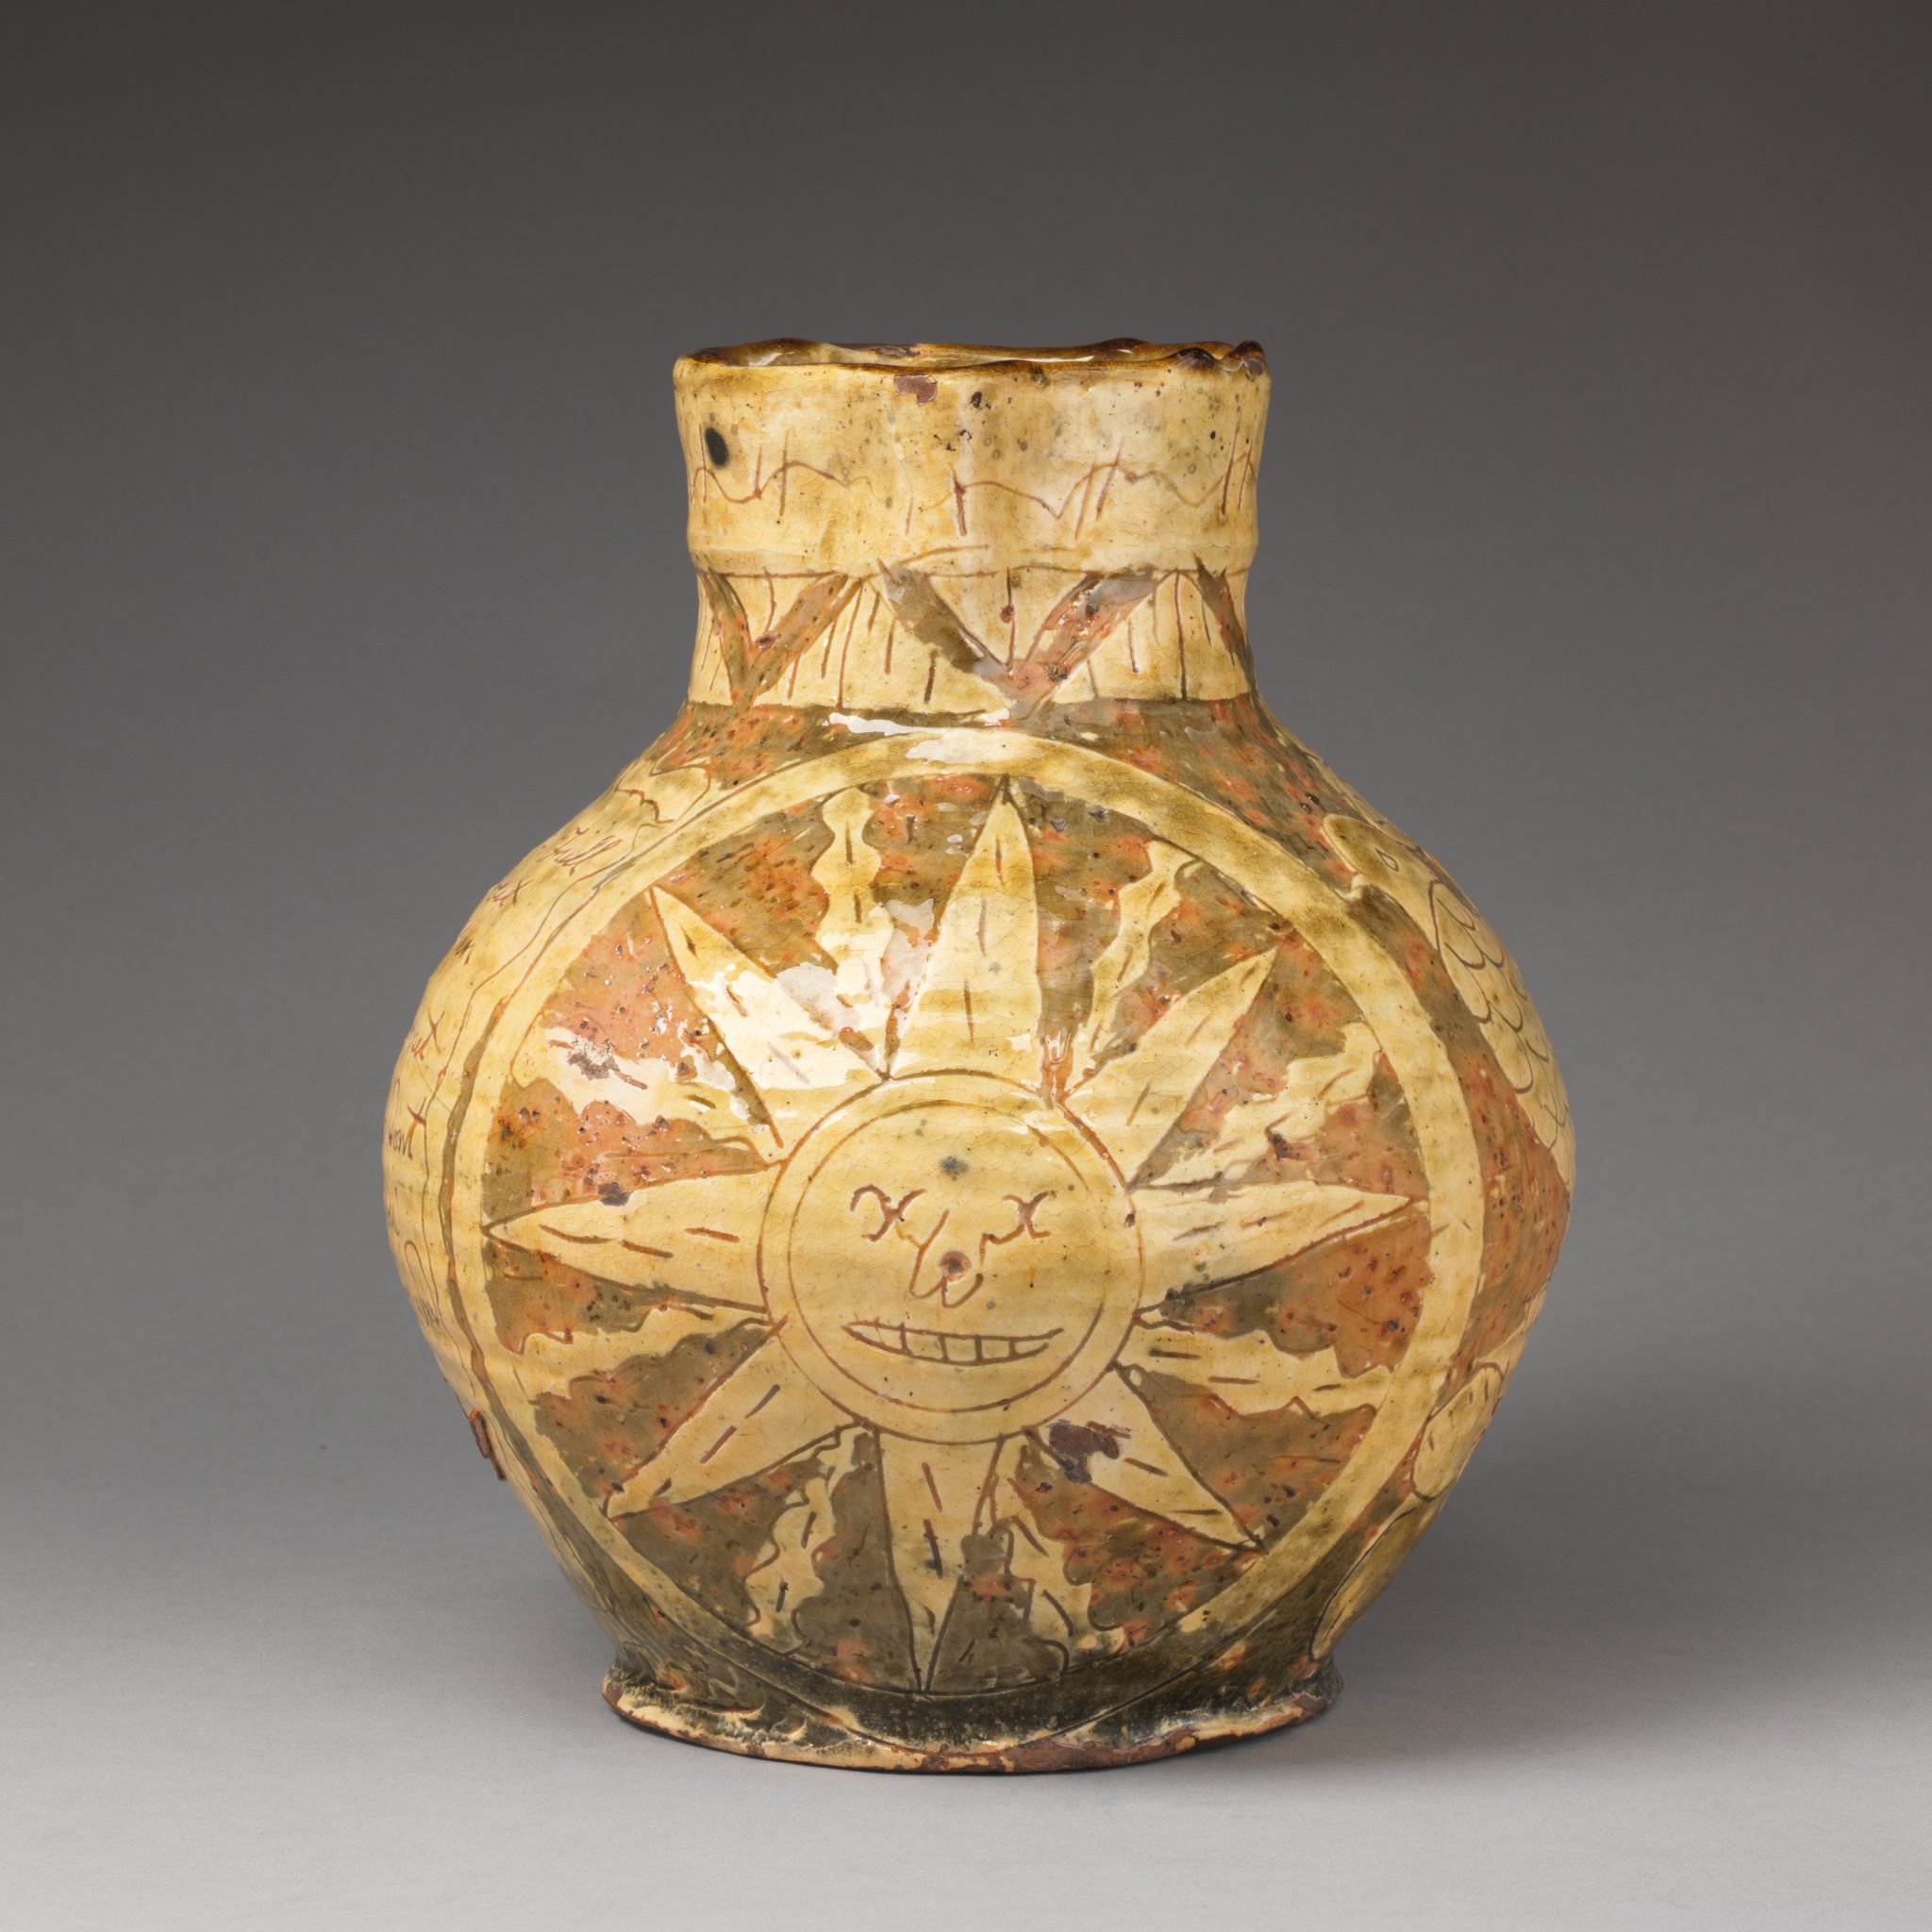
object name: harvest jug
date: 1801-1850